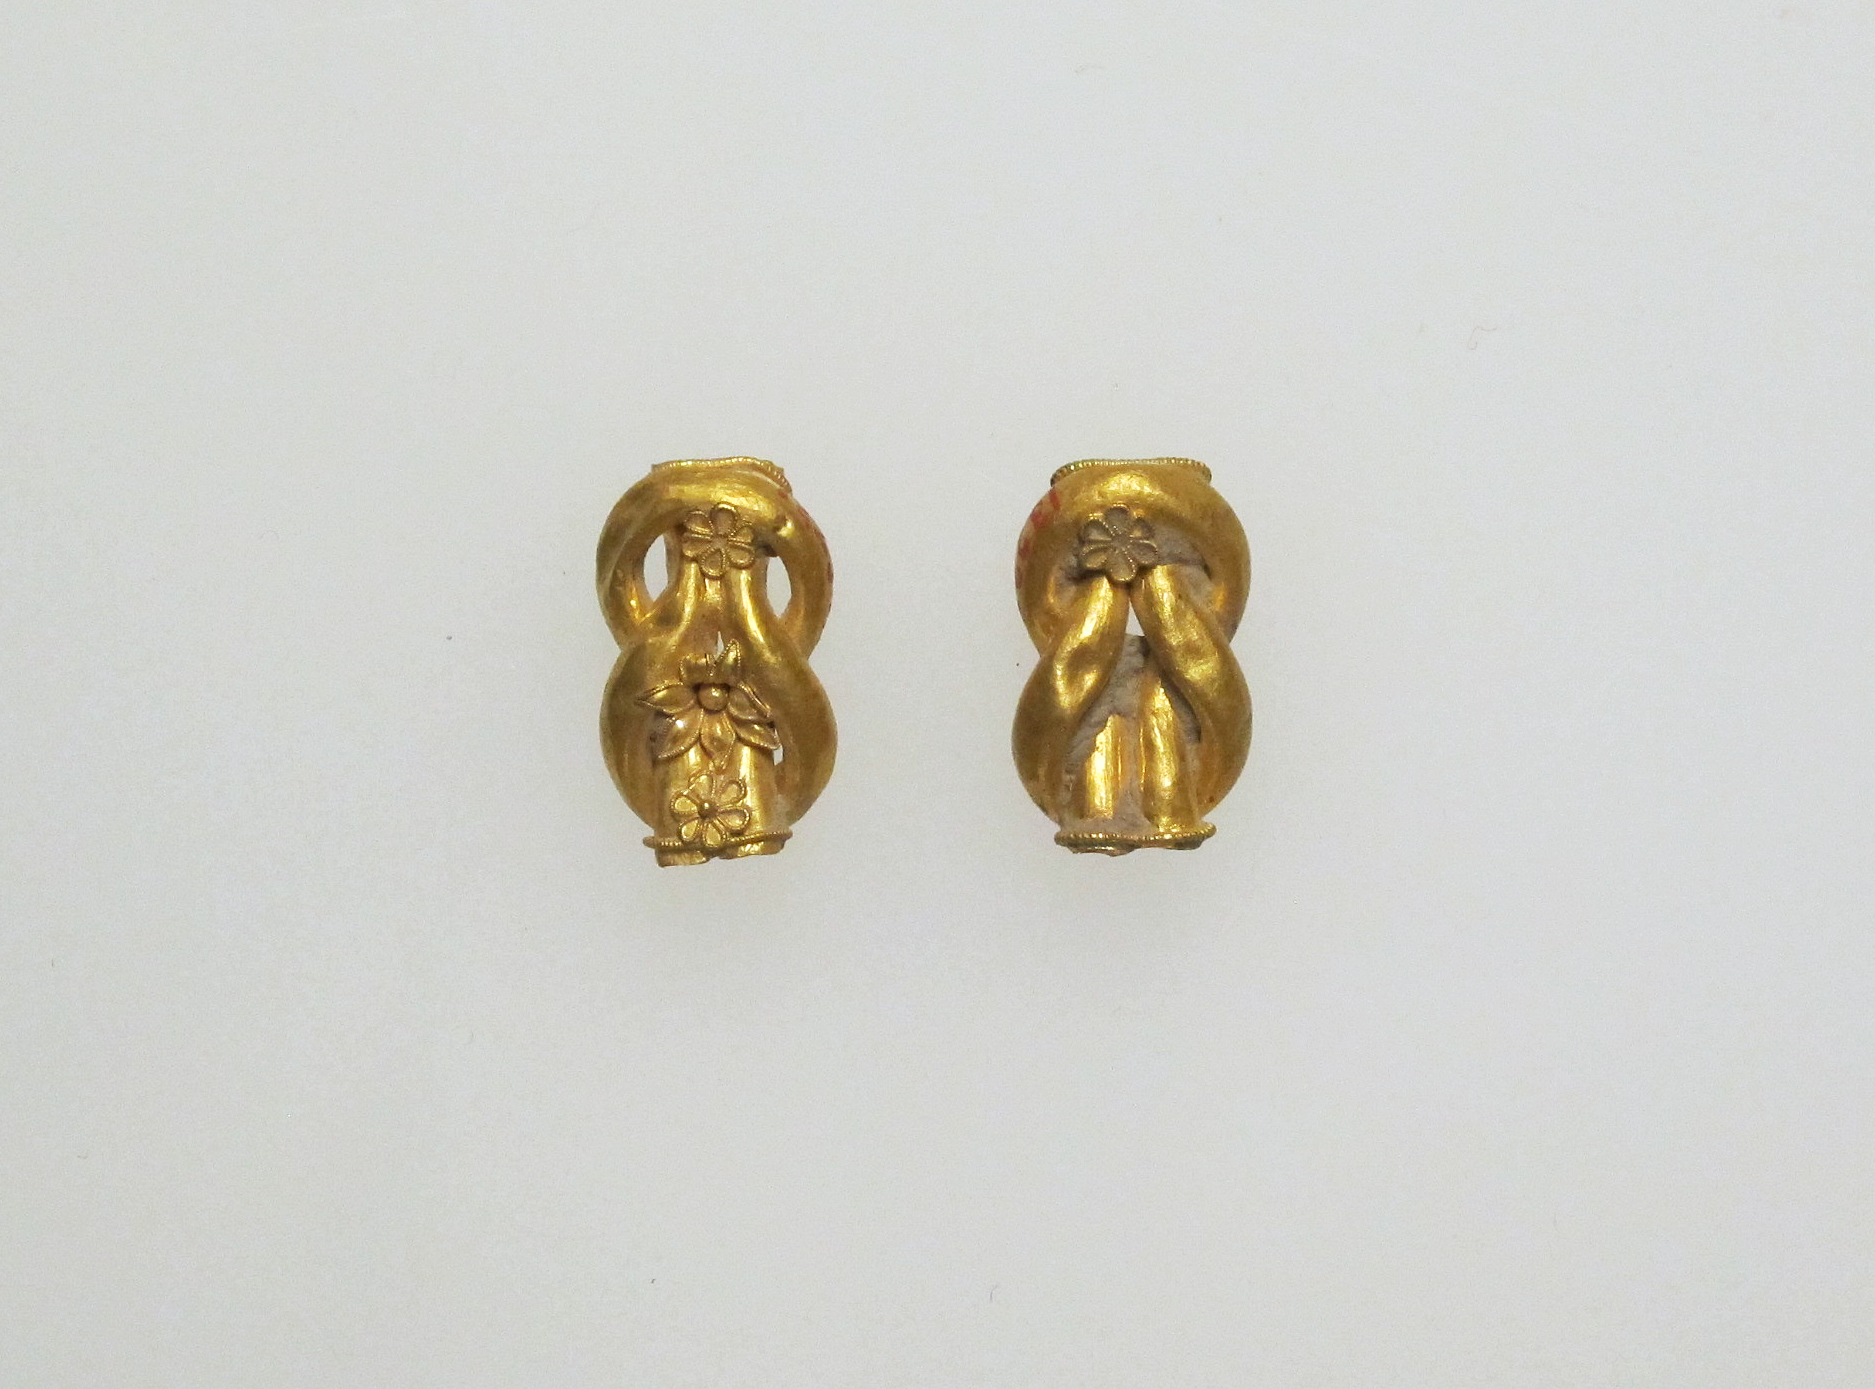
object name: necklace ornament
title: Necklace ornaments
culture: greek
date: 300-201 BCE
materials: gold